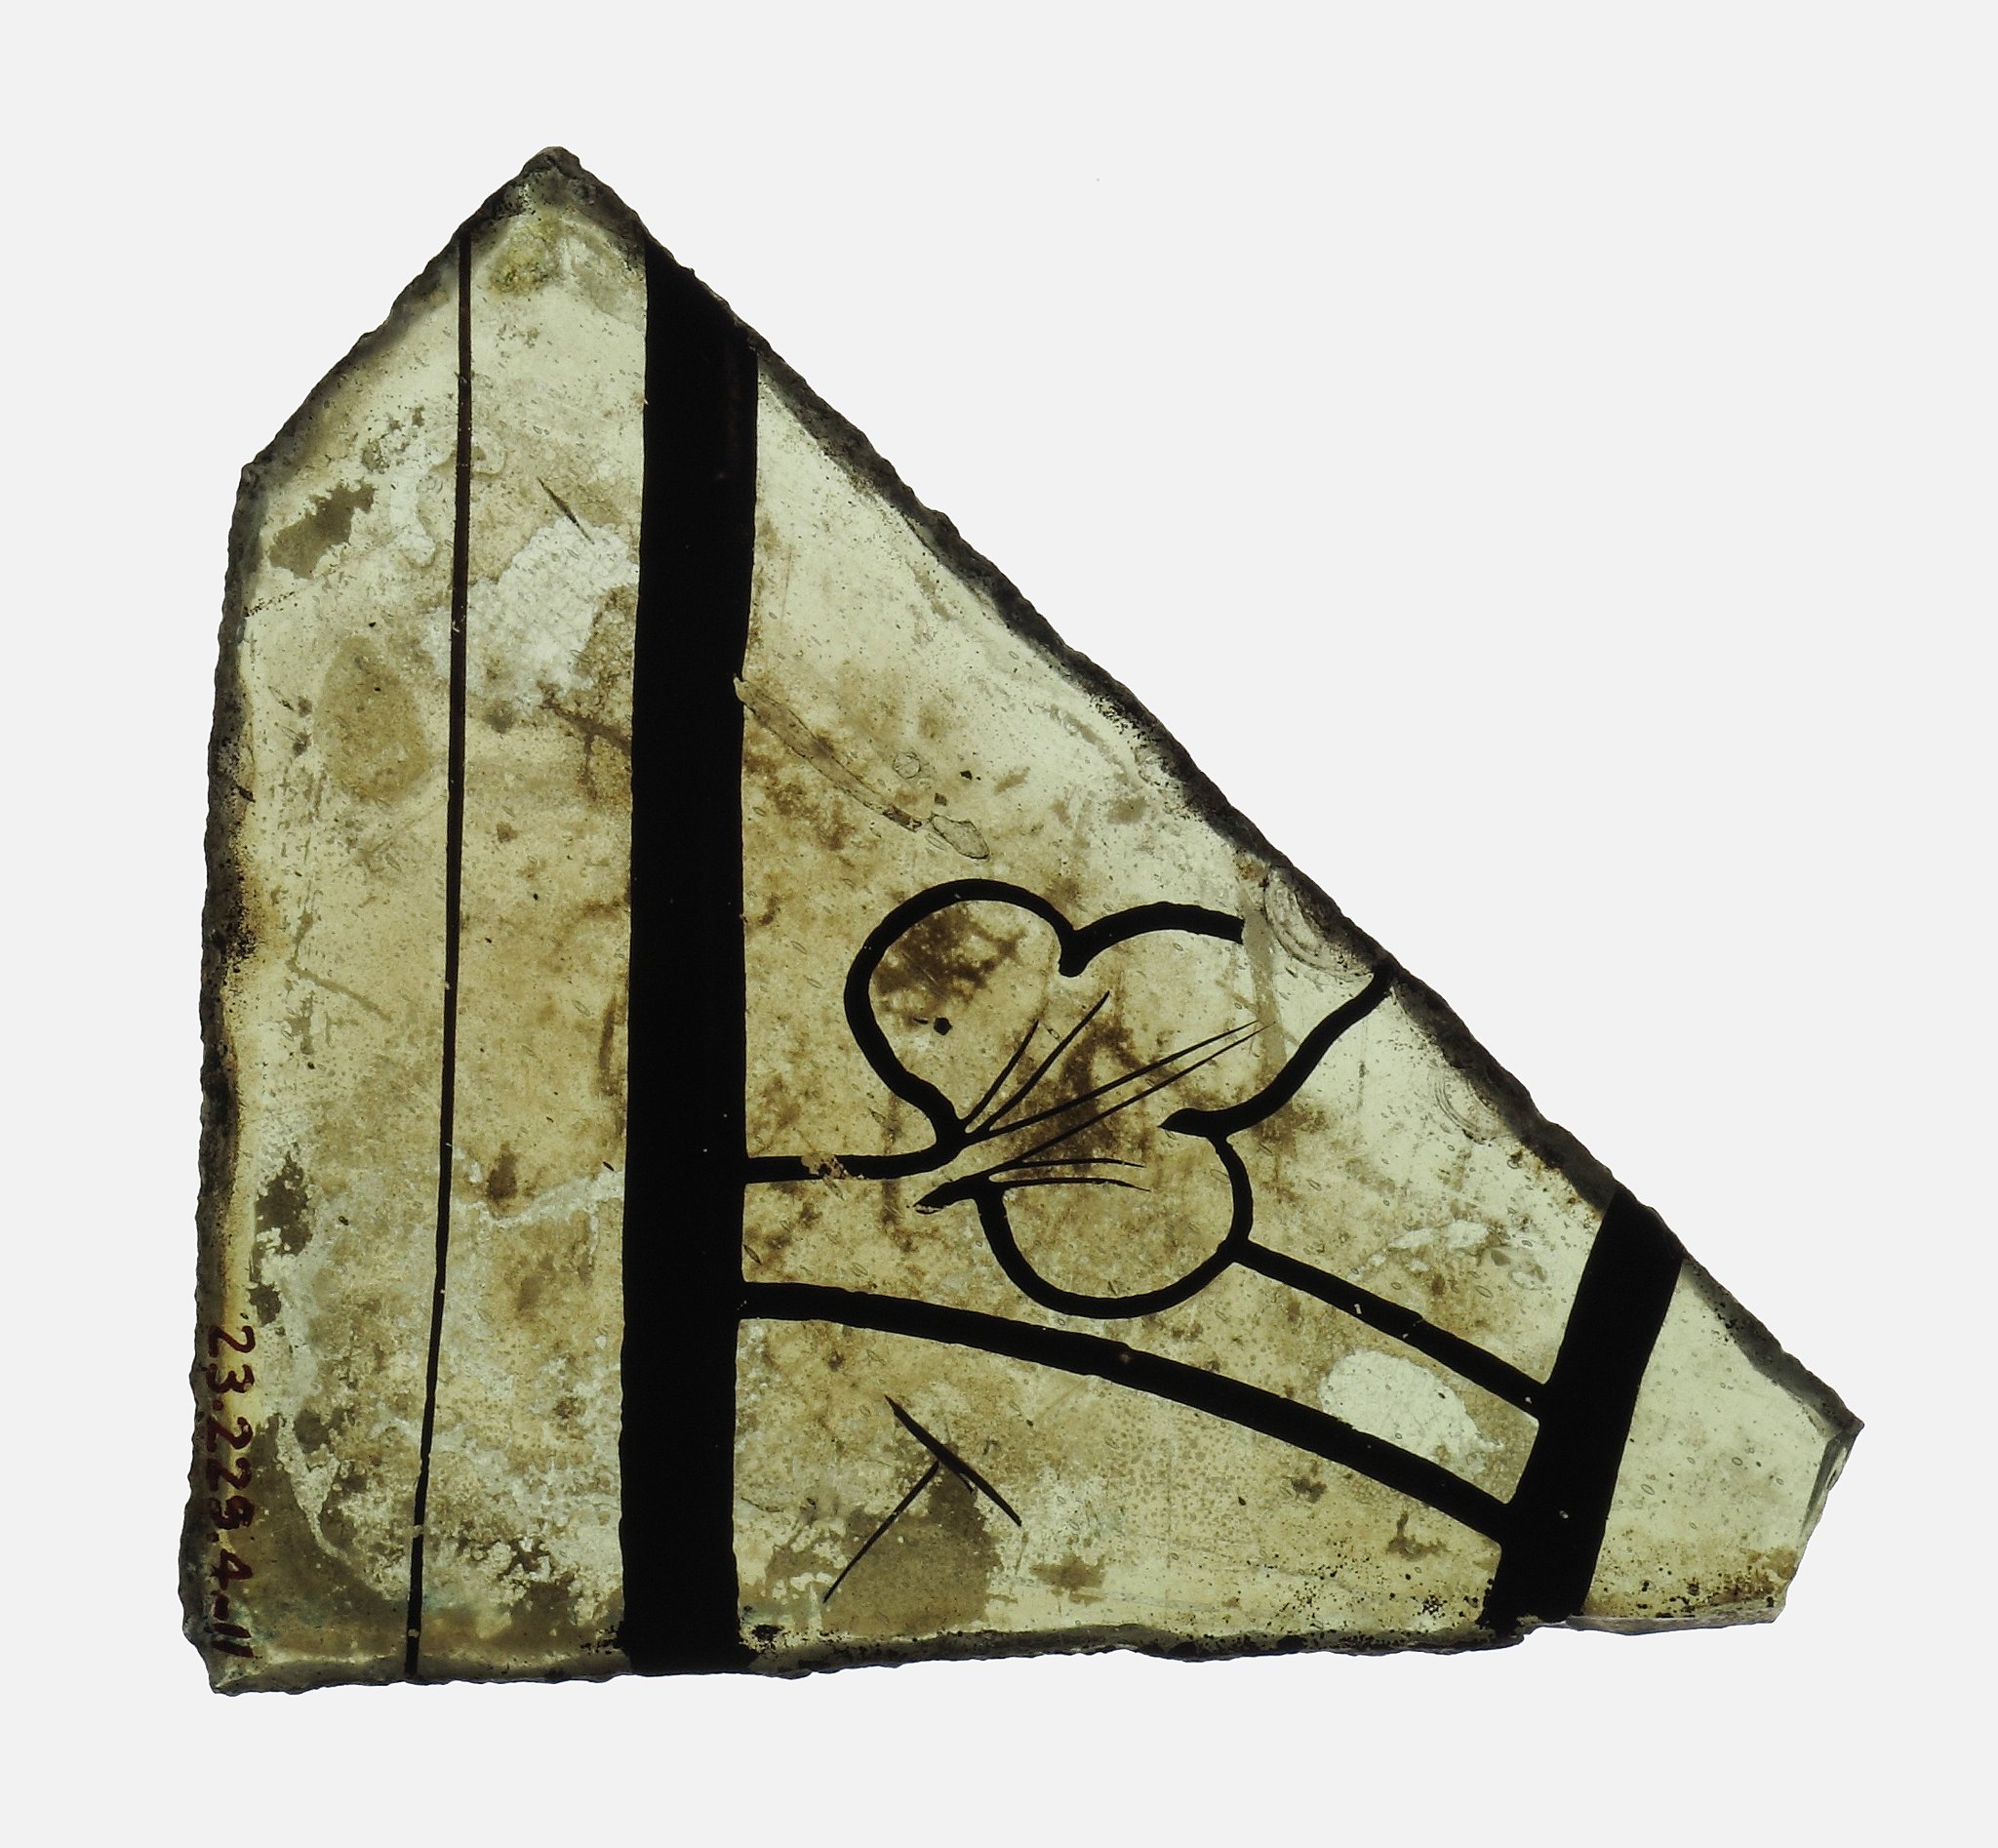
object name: fragment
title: Glass Fragment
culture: french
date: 1301-1400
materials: glass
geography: france